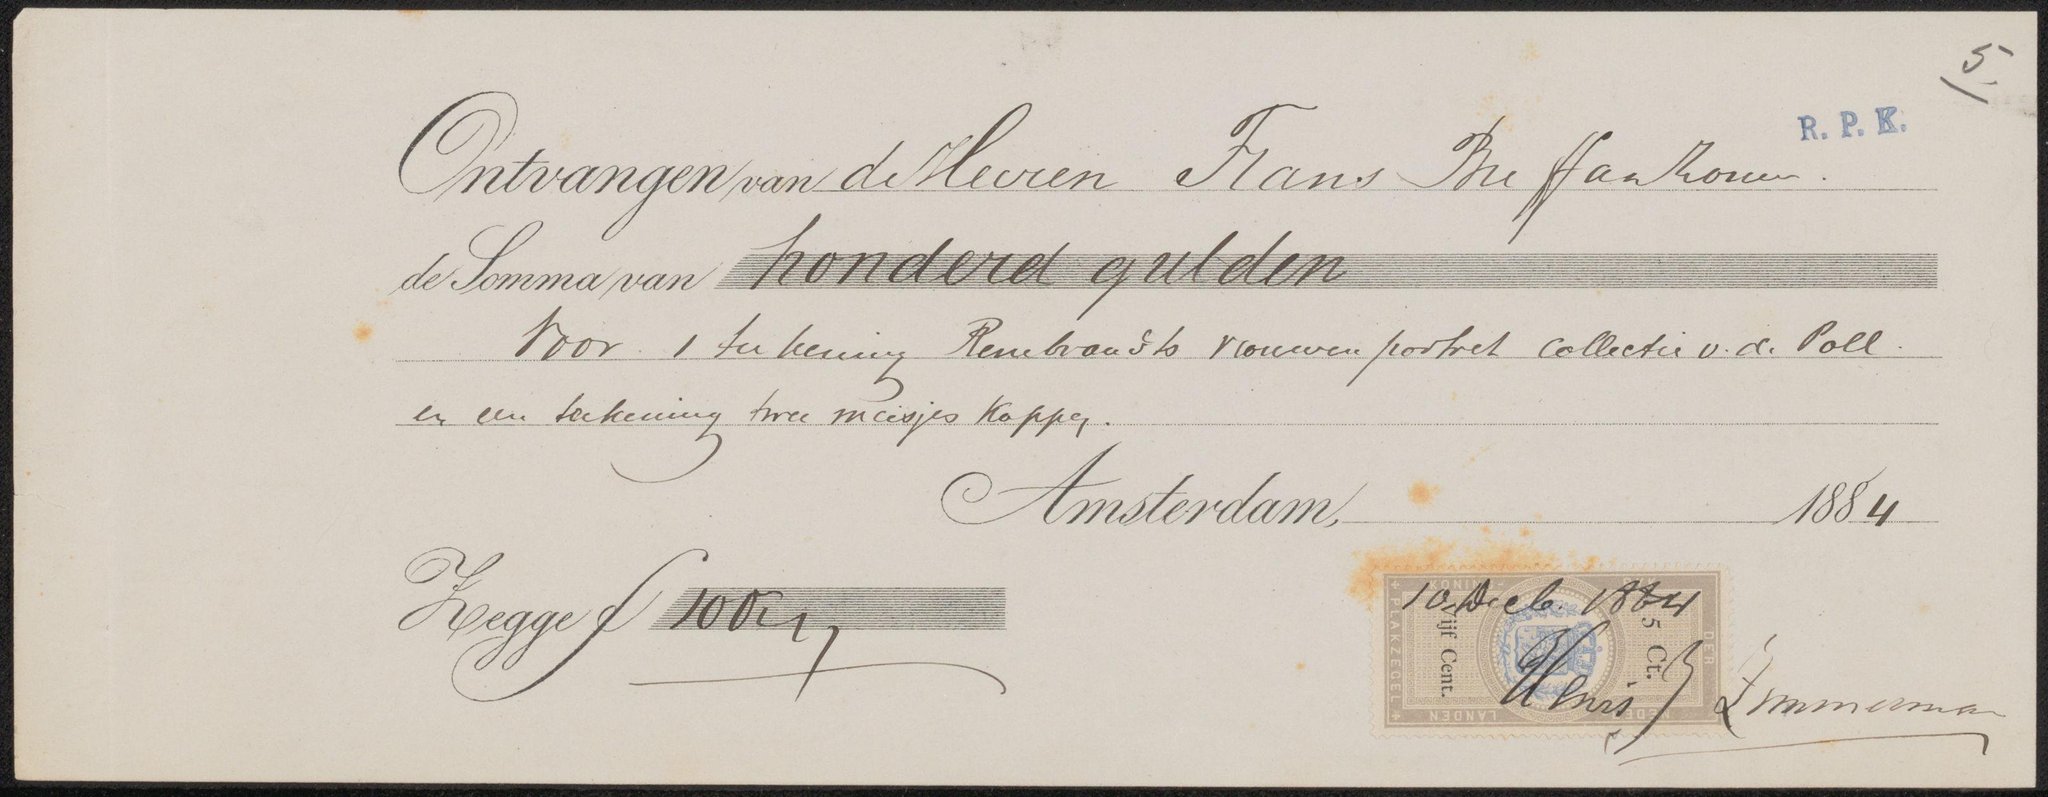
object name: ontvangstbewijs, kwitantie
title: Kwitantie voor Hendrik Jan Zimmerman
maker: hendrik jan zimmerman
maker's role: bookseller, publisher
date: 1884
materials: ink, paper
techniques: pen, printing, writing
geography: amsterdam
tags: utrecht, drawing, money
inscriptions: collector's mark: Lugt 2233